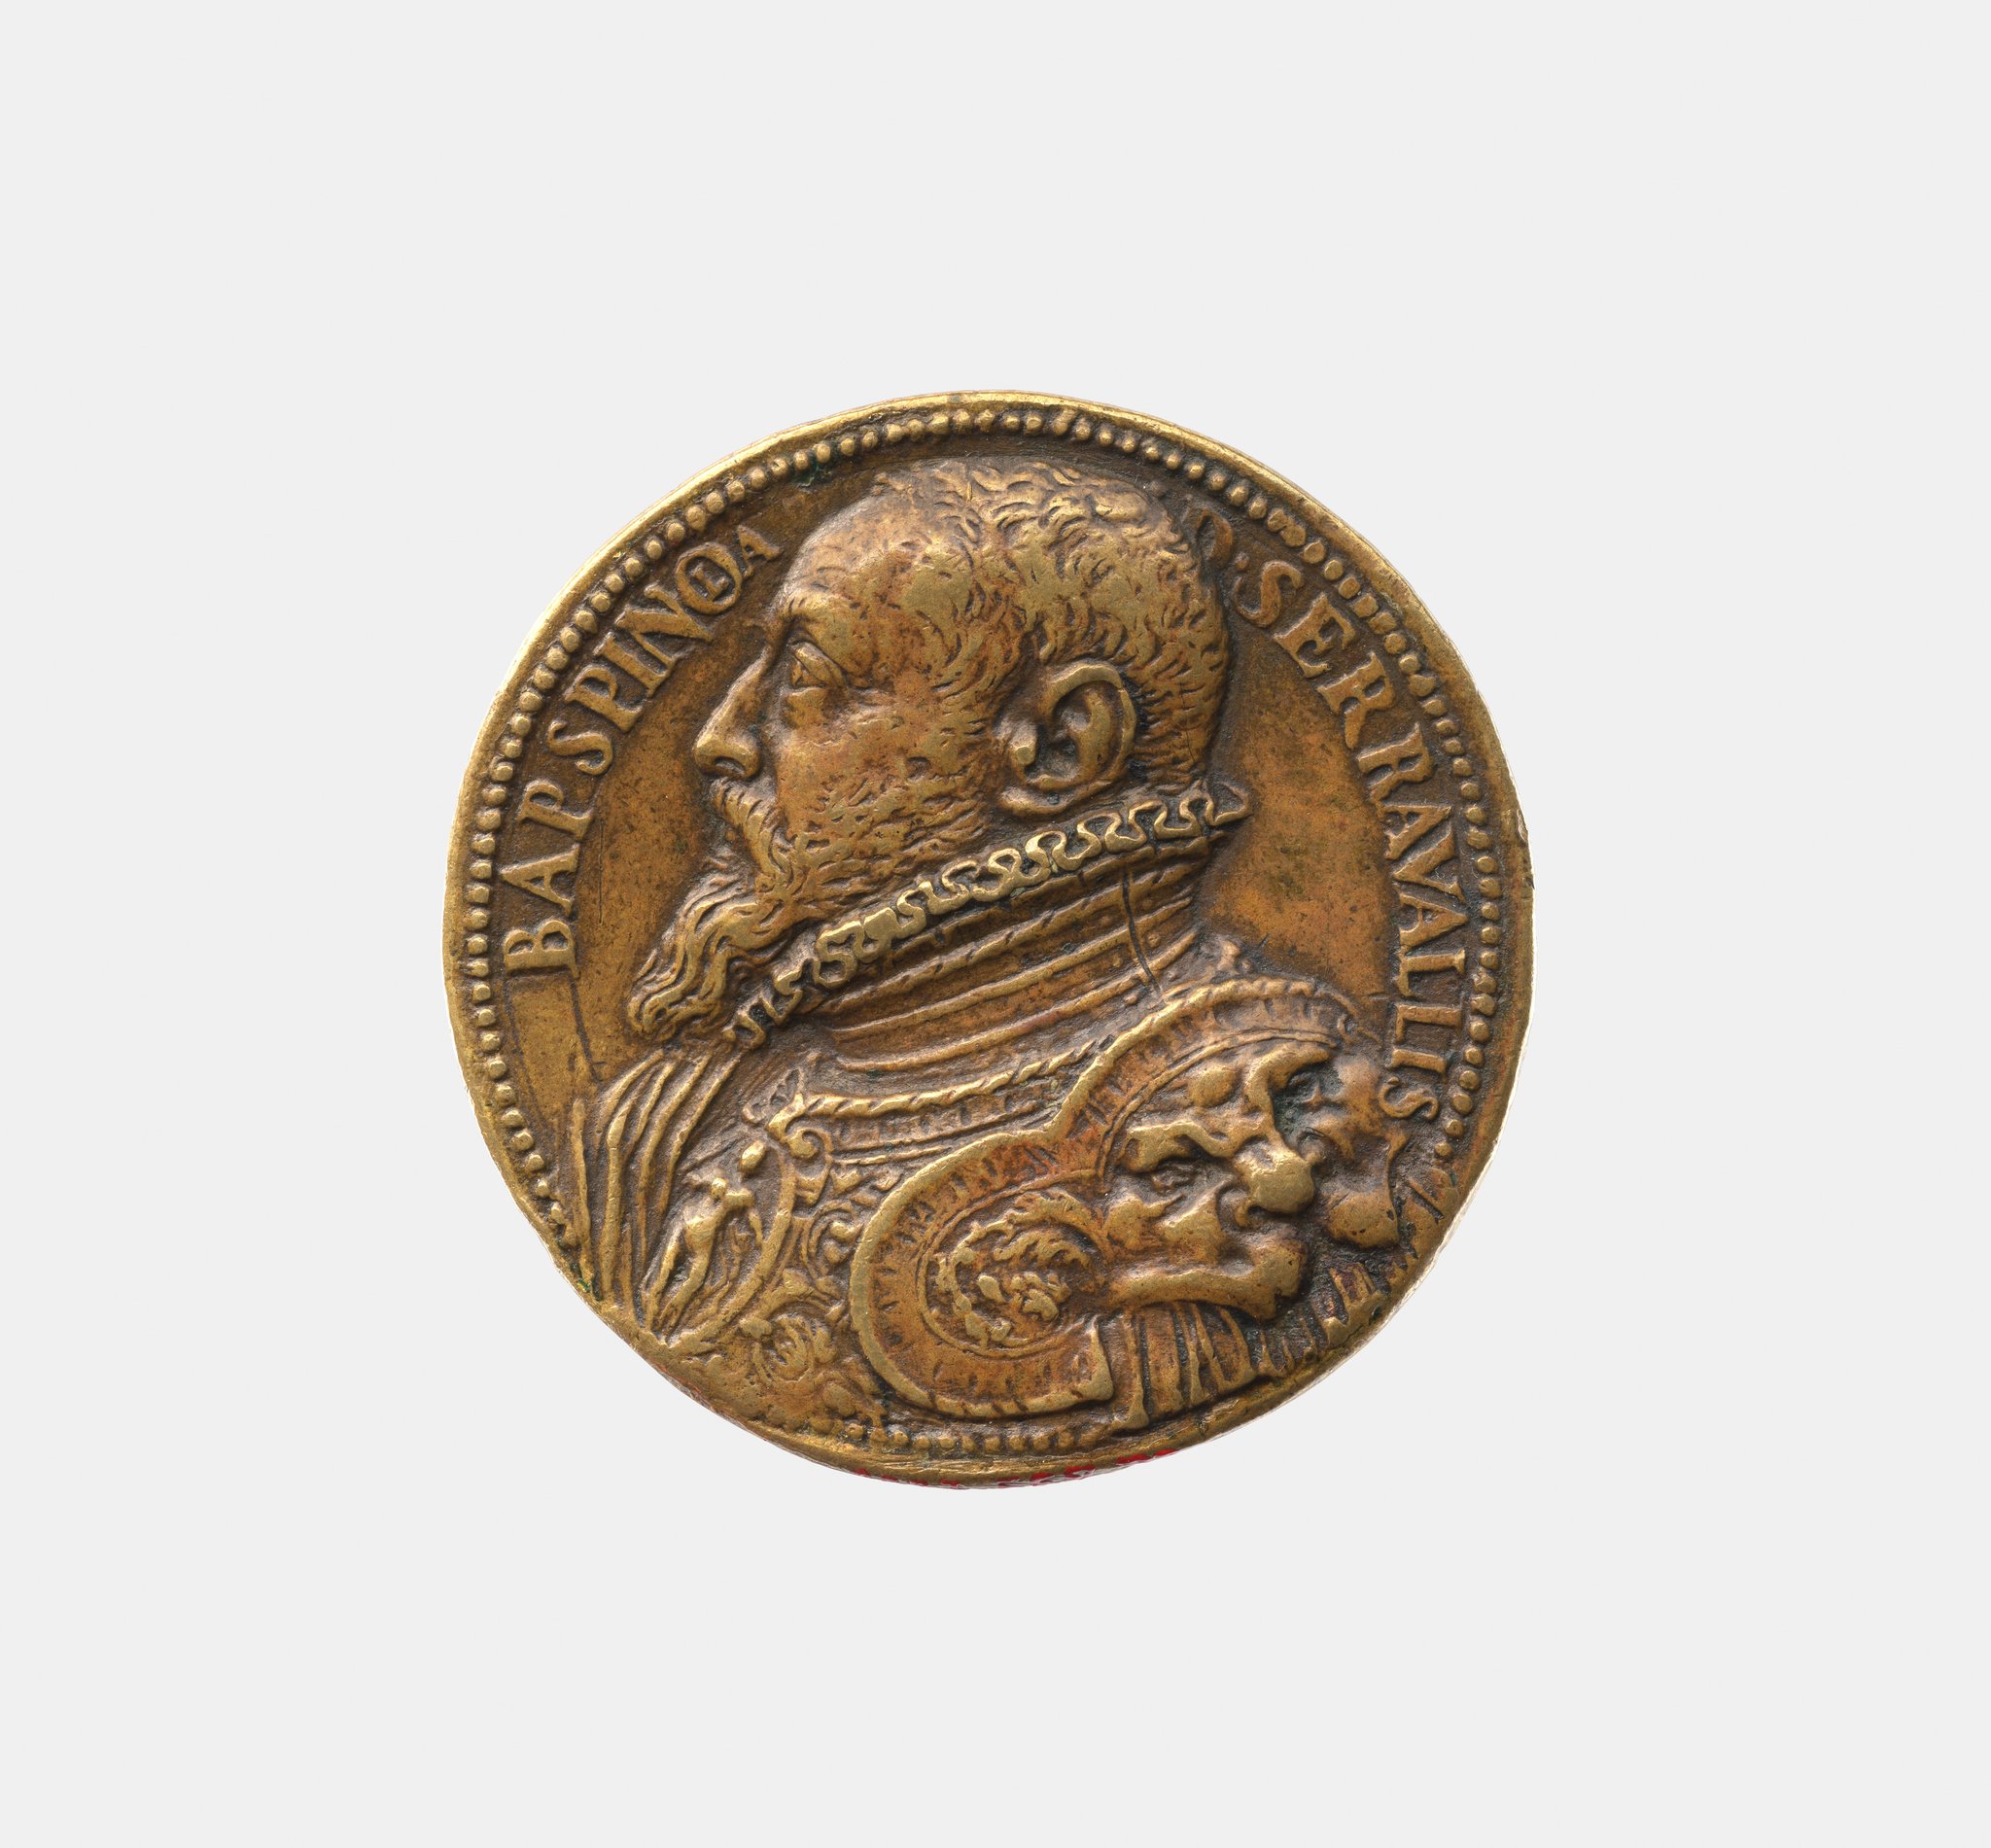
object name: medal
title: Battista Spinola de Serravalis b. 1537, Genoese nobleman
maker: Anonymous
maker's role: artist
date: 1500-1599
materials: bronze